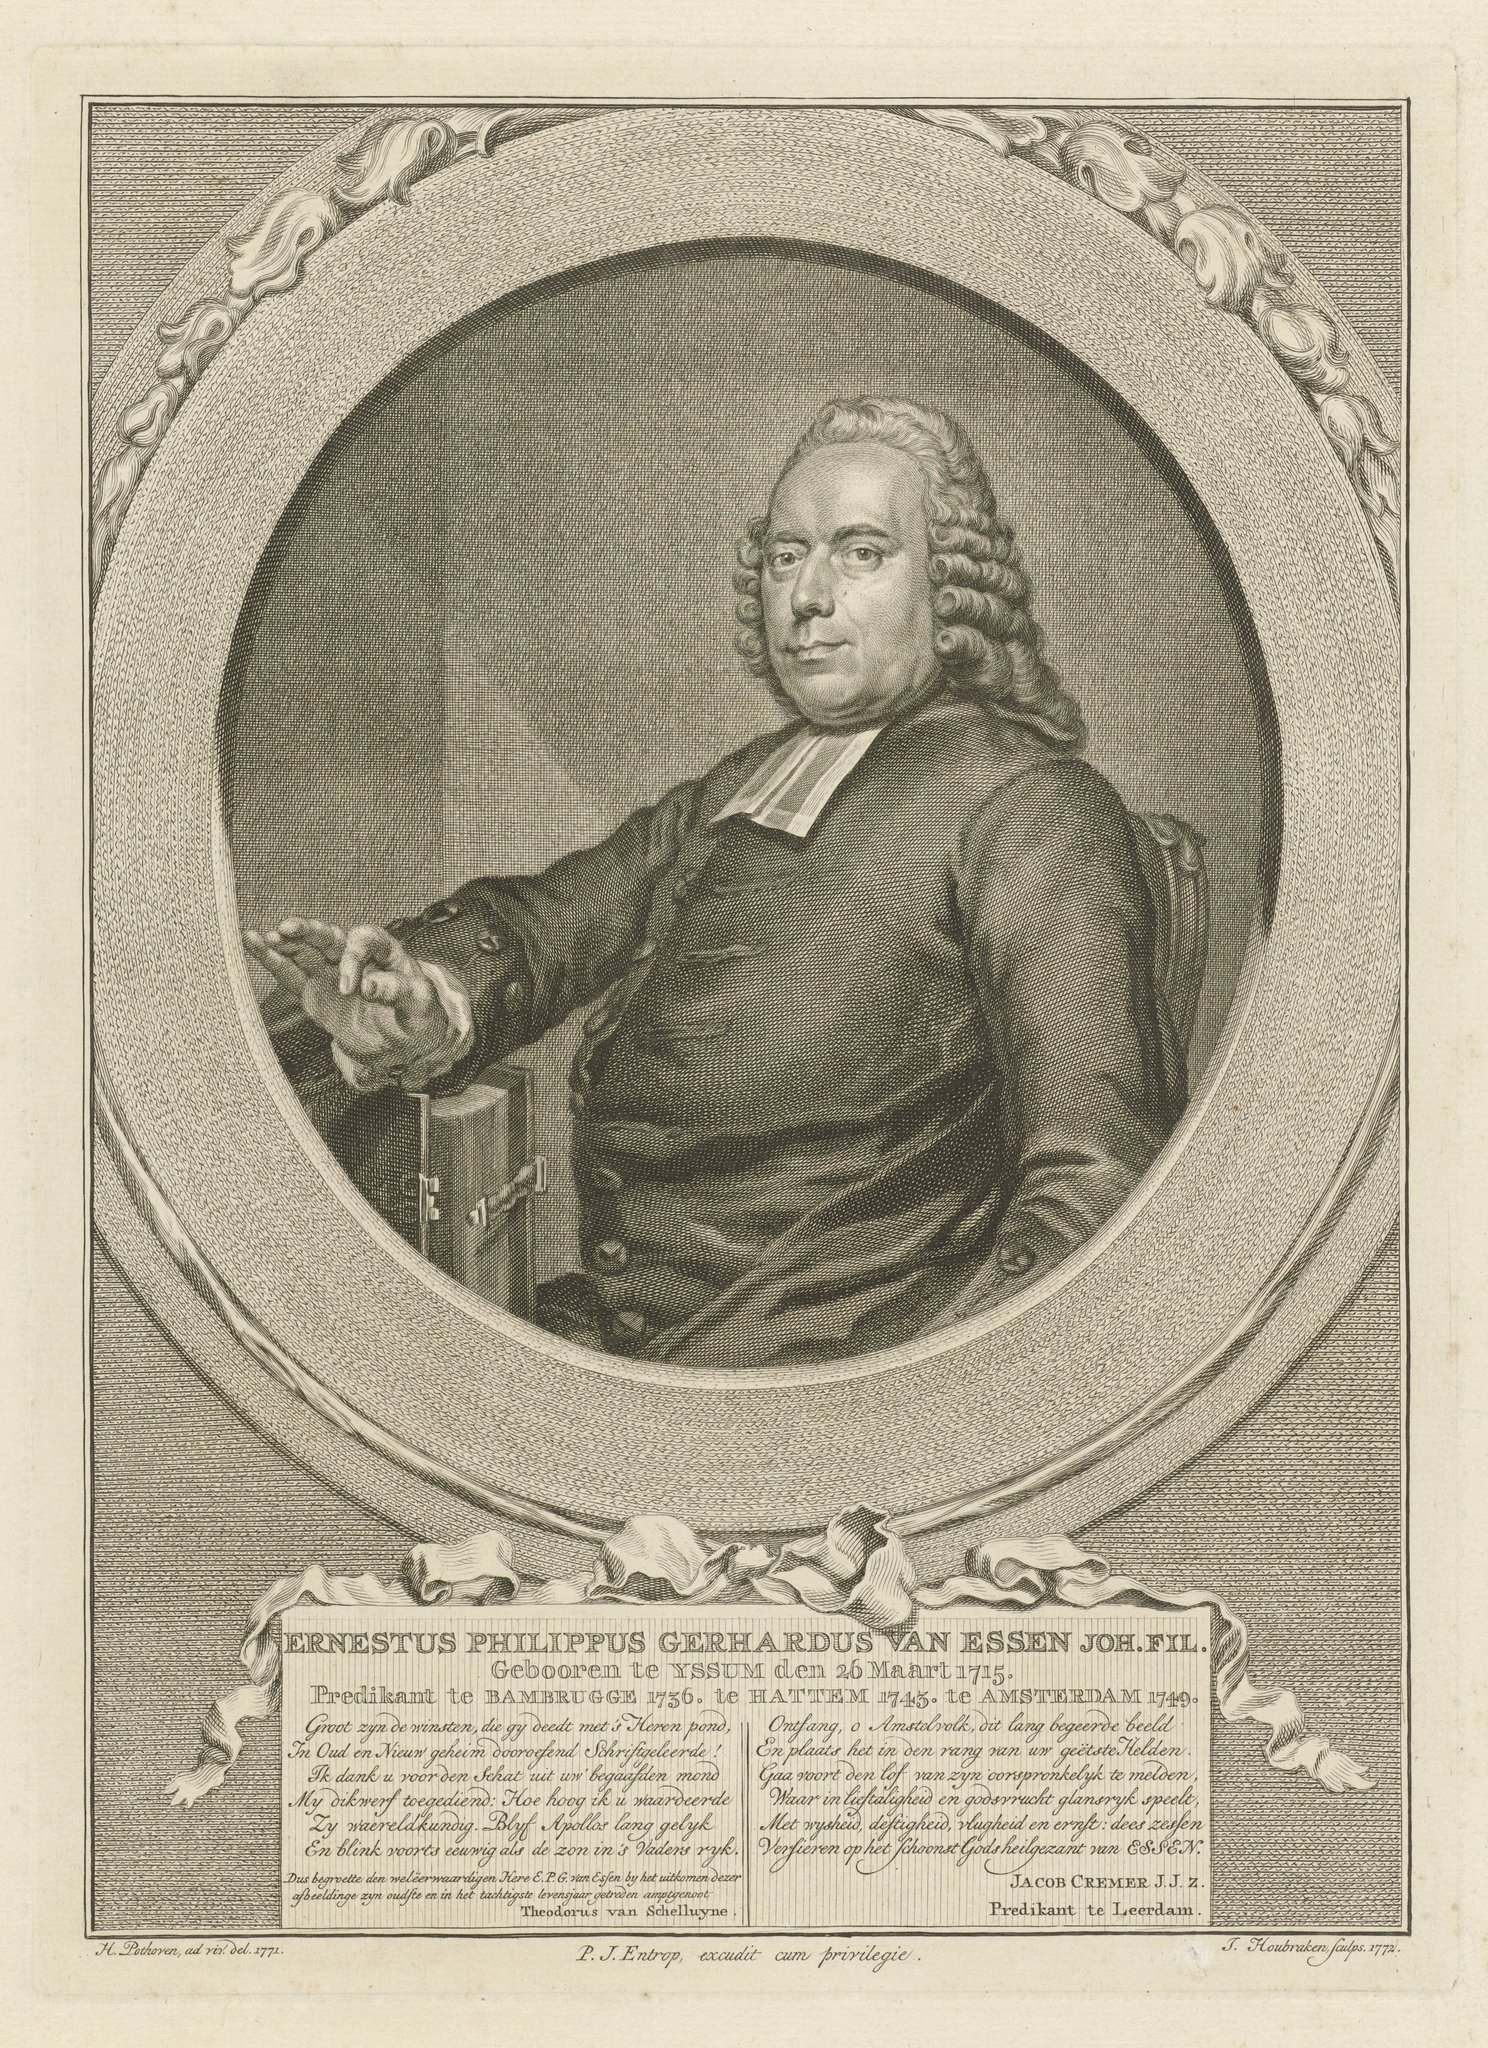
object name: print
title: Ernestus Philippus Gerhardus van Essen Joh. Fil.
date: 1772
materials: paper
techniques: engraving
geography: amsterdam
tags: the bible as a book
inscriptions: collector's mark: Lugt 2228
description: Portret ten halven lijve naar links van de predikant Ernestus Philippus Gerhardus van Essen in een medaillon, zittend op een stoel en met zijn rechterarm rustend op een bijbel. Onder het medaillon een veld waarop zijn naam en gegevens in drie regels in het Nederlands en daaronder twee kolommen met elk een zesregelig vers in het Nederlands.